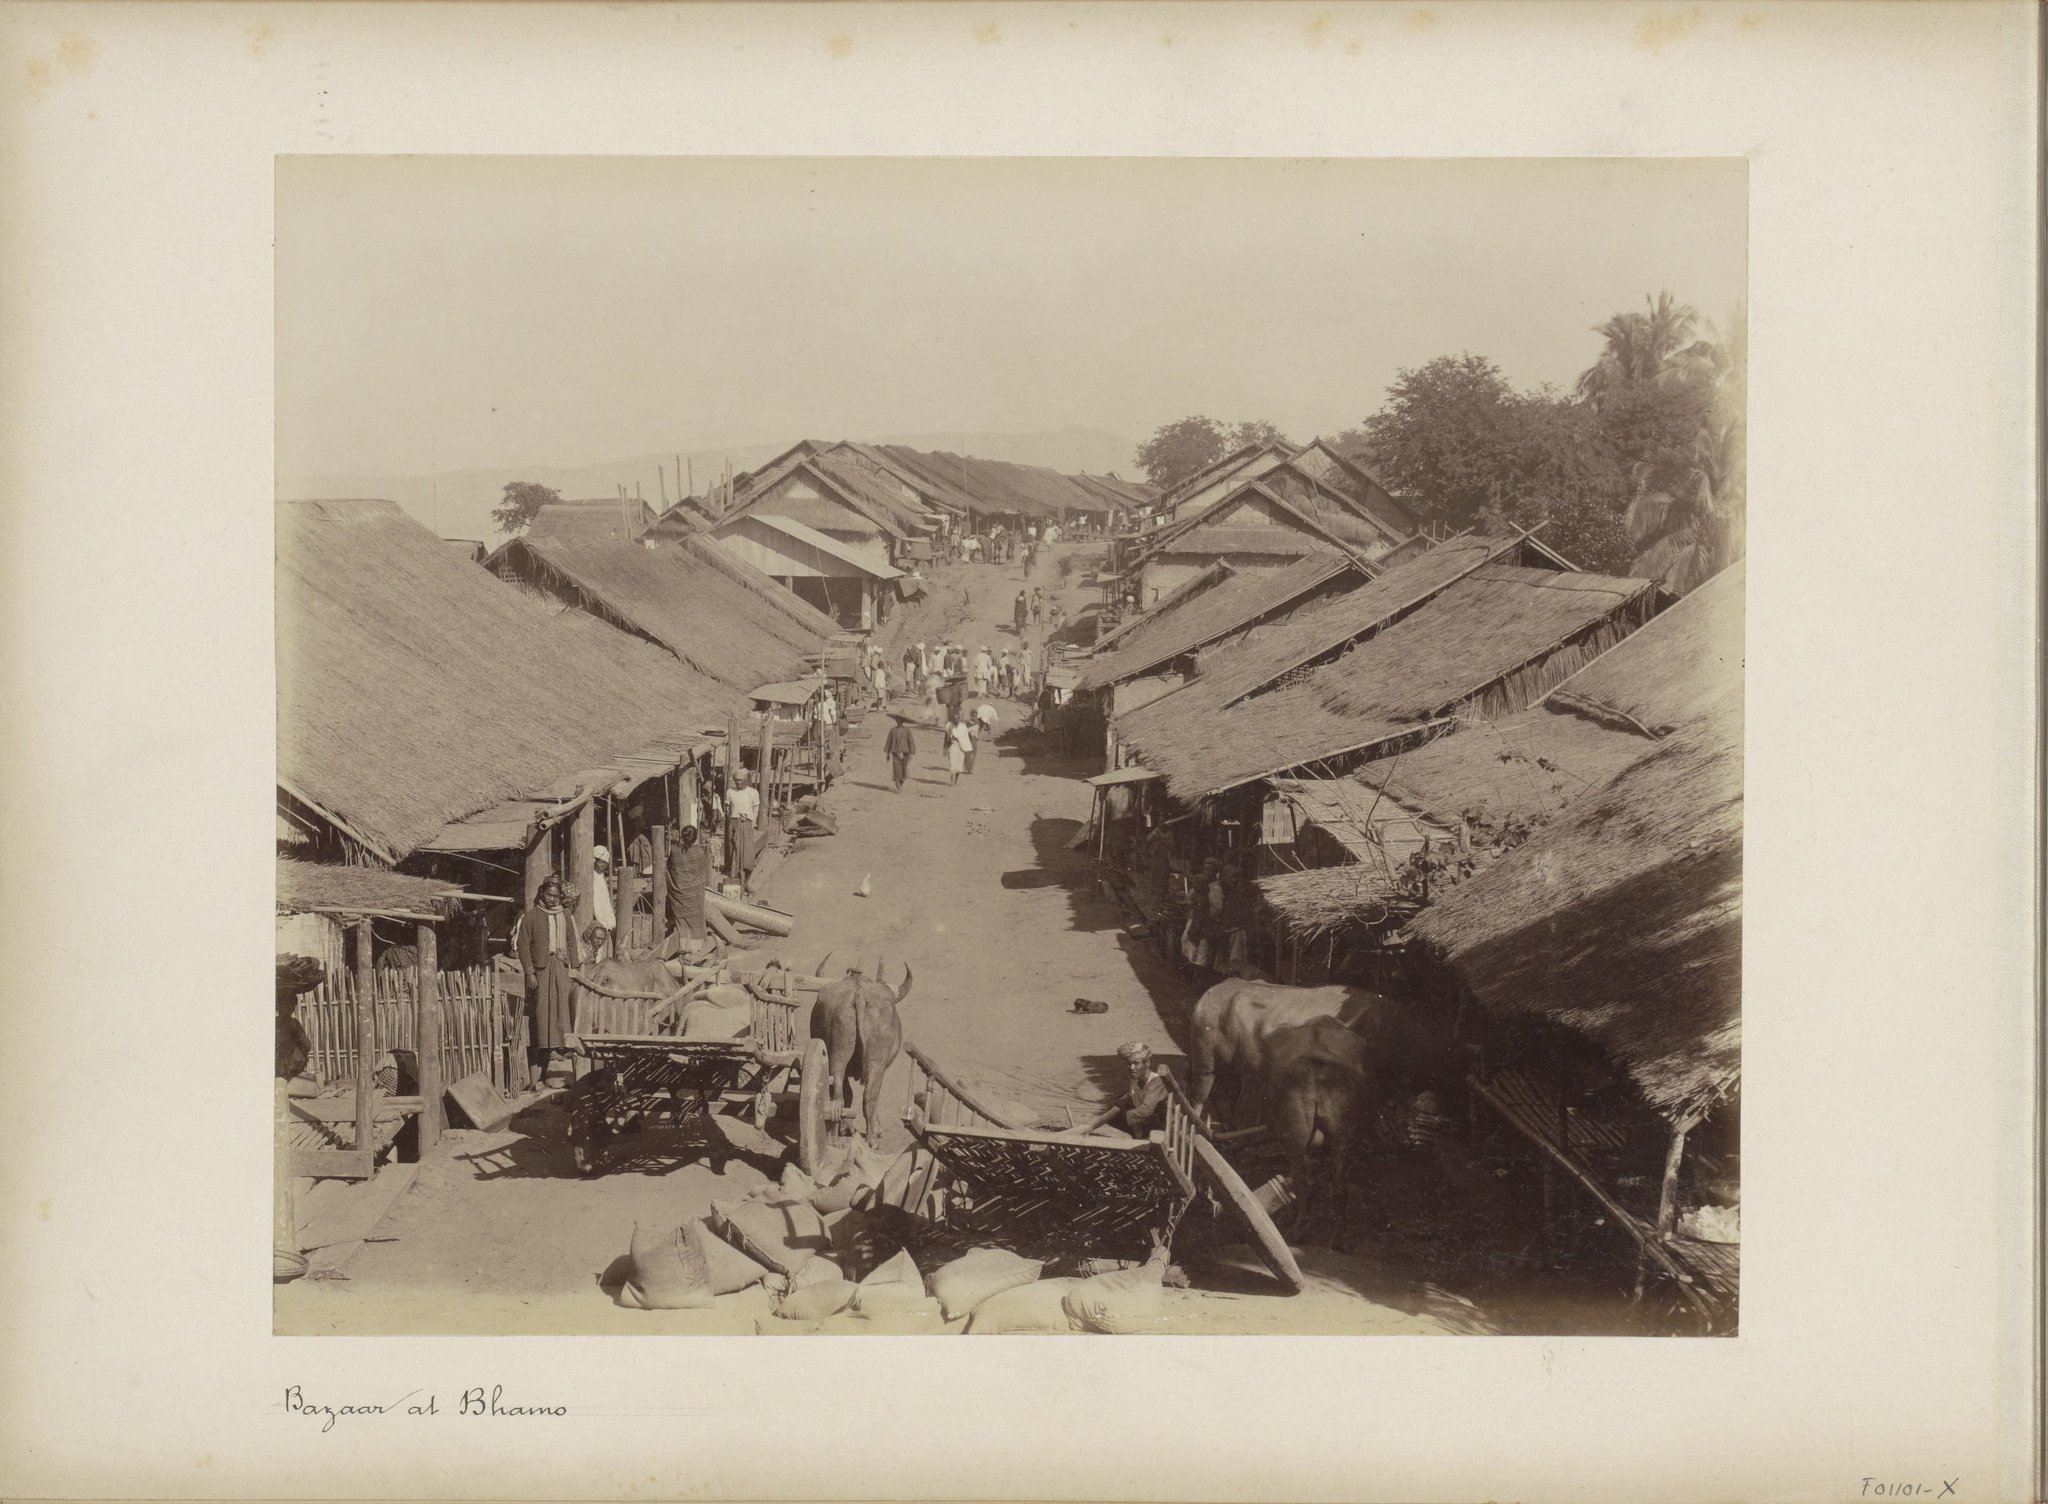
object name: photograph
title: Market street in Bhamo, Myanmar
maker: Anonymous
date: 1885-1886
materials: cardboard, paper, photographic support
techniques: albumen print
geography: bhamo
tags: two-wheeled, animal-drawn vehicle, market, street (+ city(-scape) with figures, staffage)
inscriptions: caption: ‘Bazaar at Bhamo’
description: Onderdeel van Reisalbum met foto's van bezienswaardigheden in Birma.